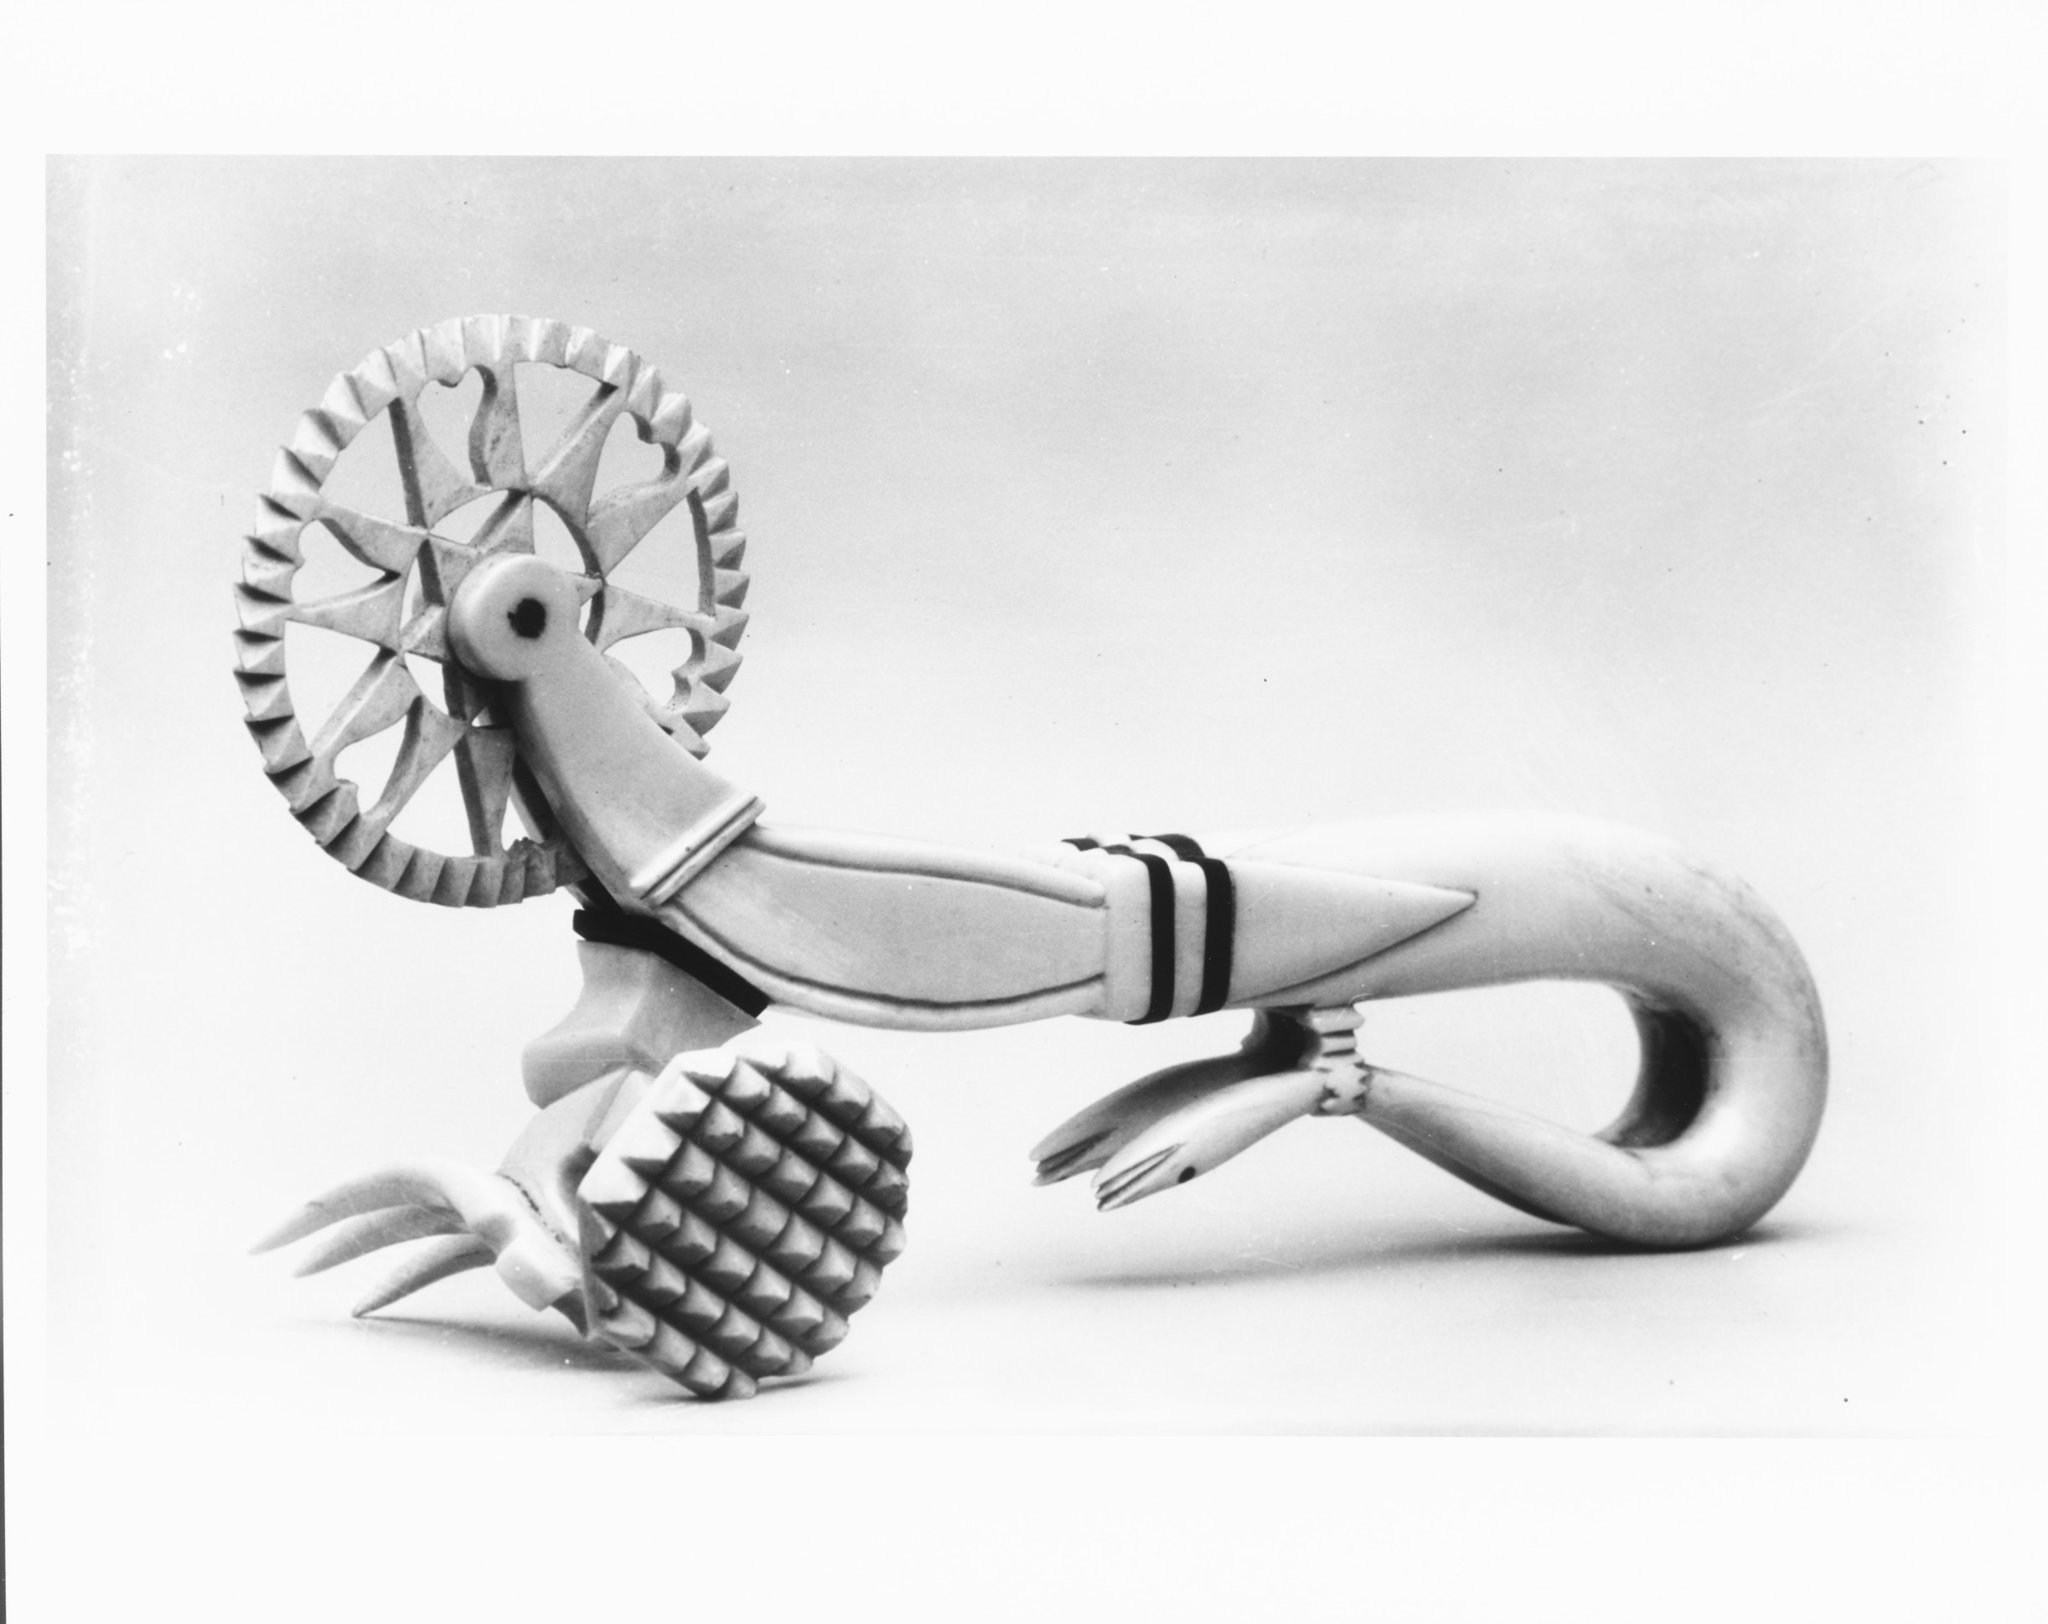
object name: jagging wheel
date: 1800-1900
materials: ivory